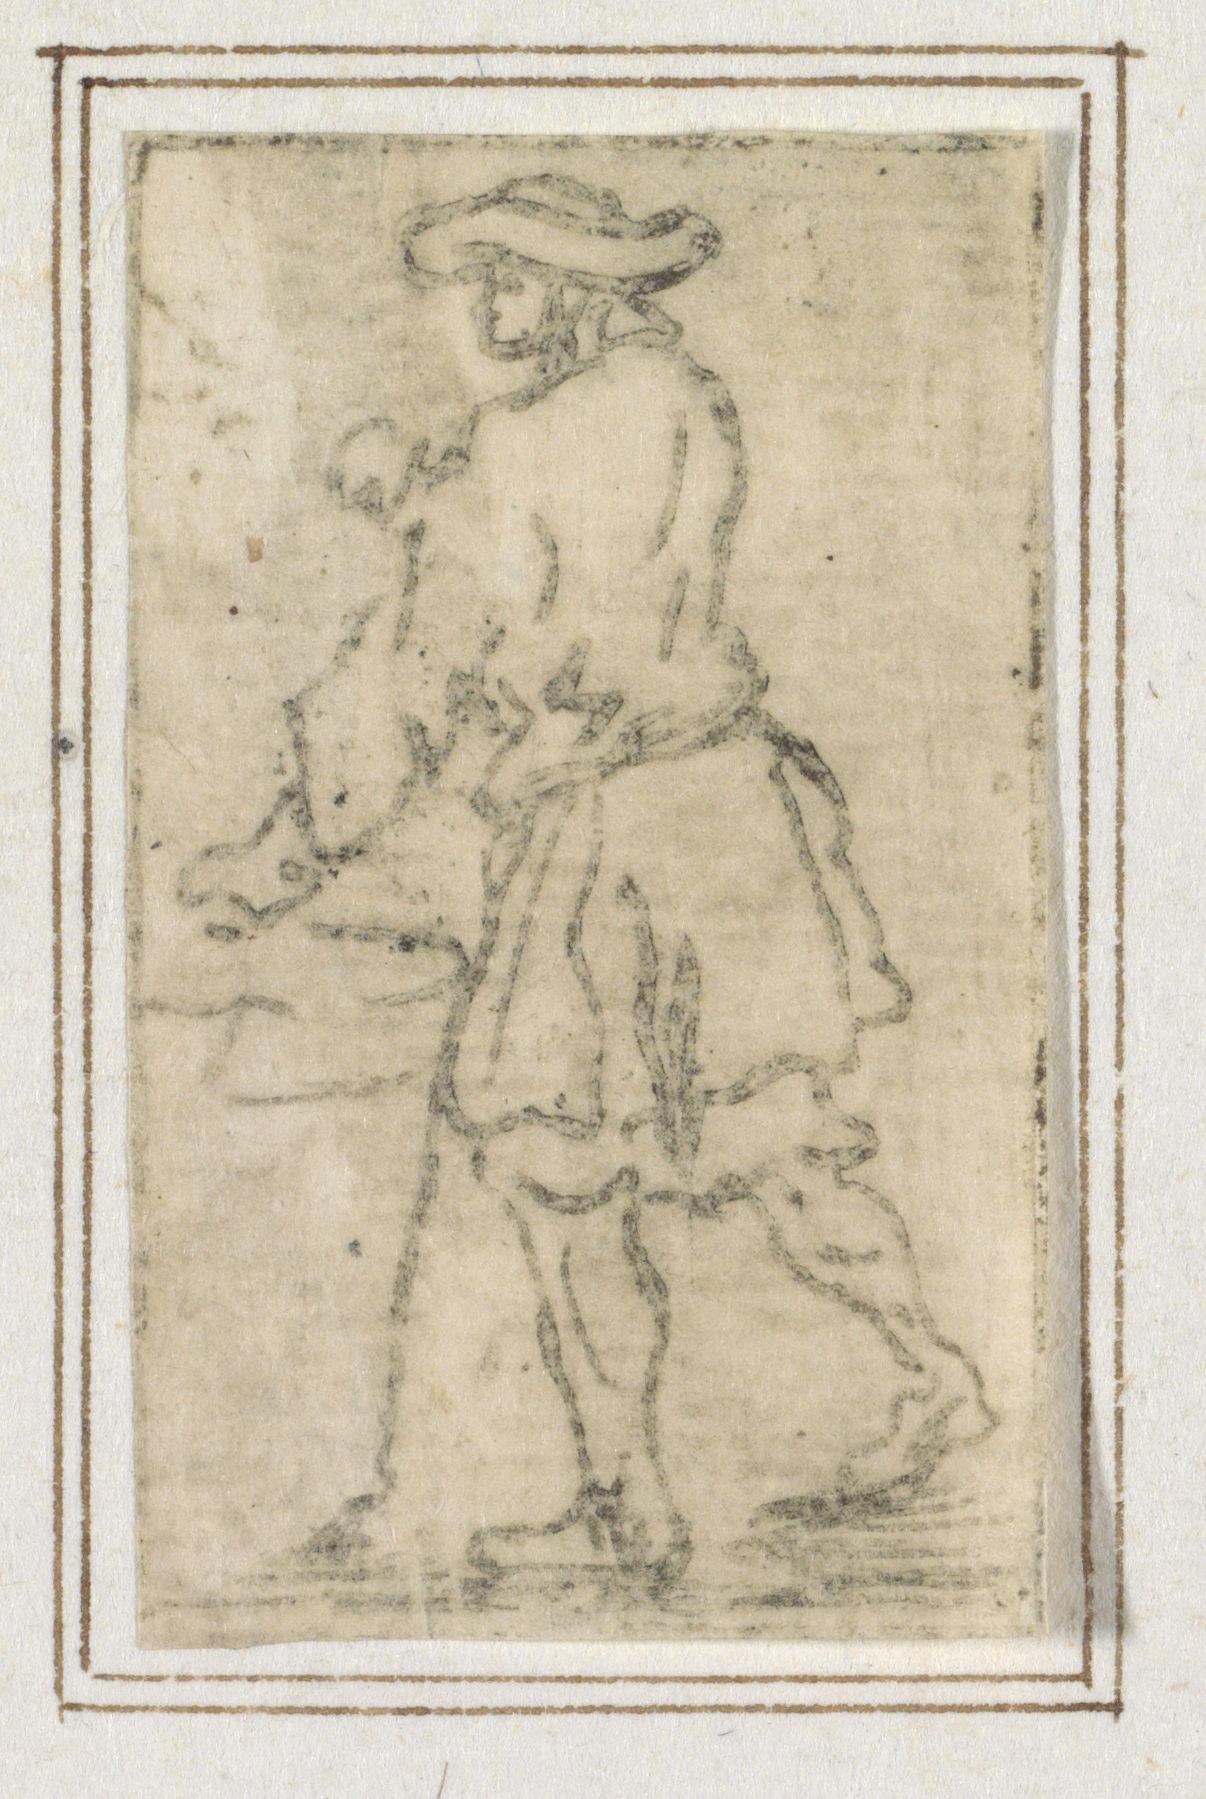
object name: print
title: Staande man naar links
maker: Anonymous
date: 1700-1900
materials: paper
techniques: etching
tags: standing figure